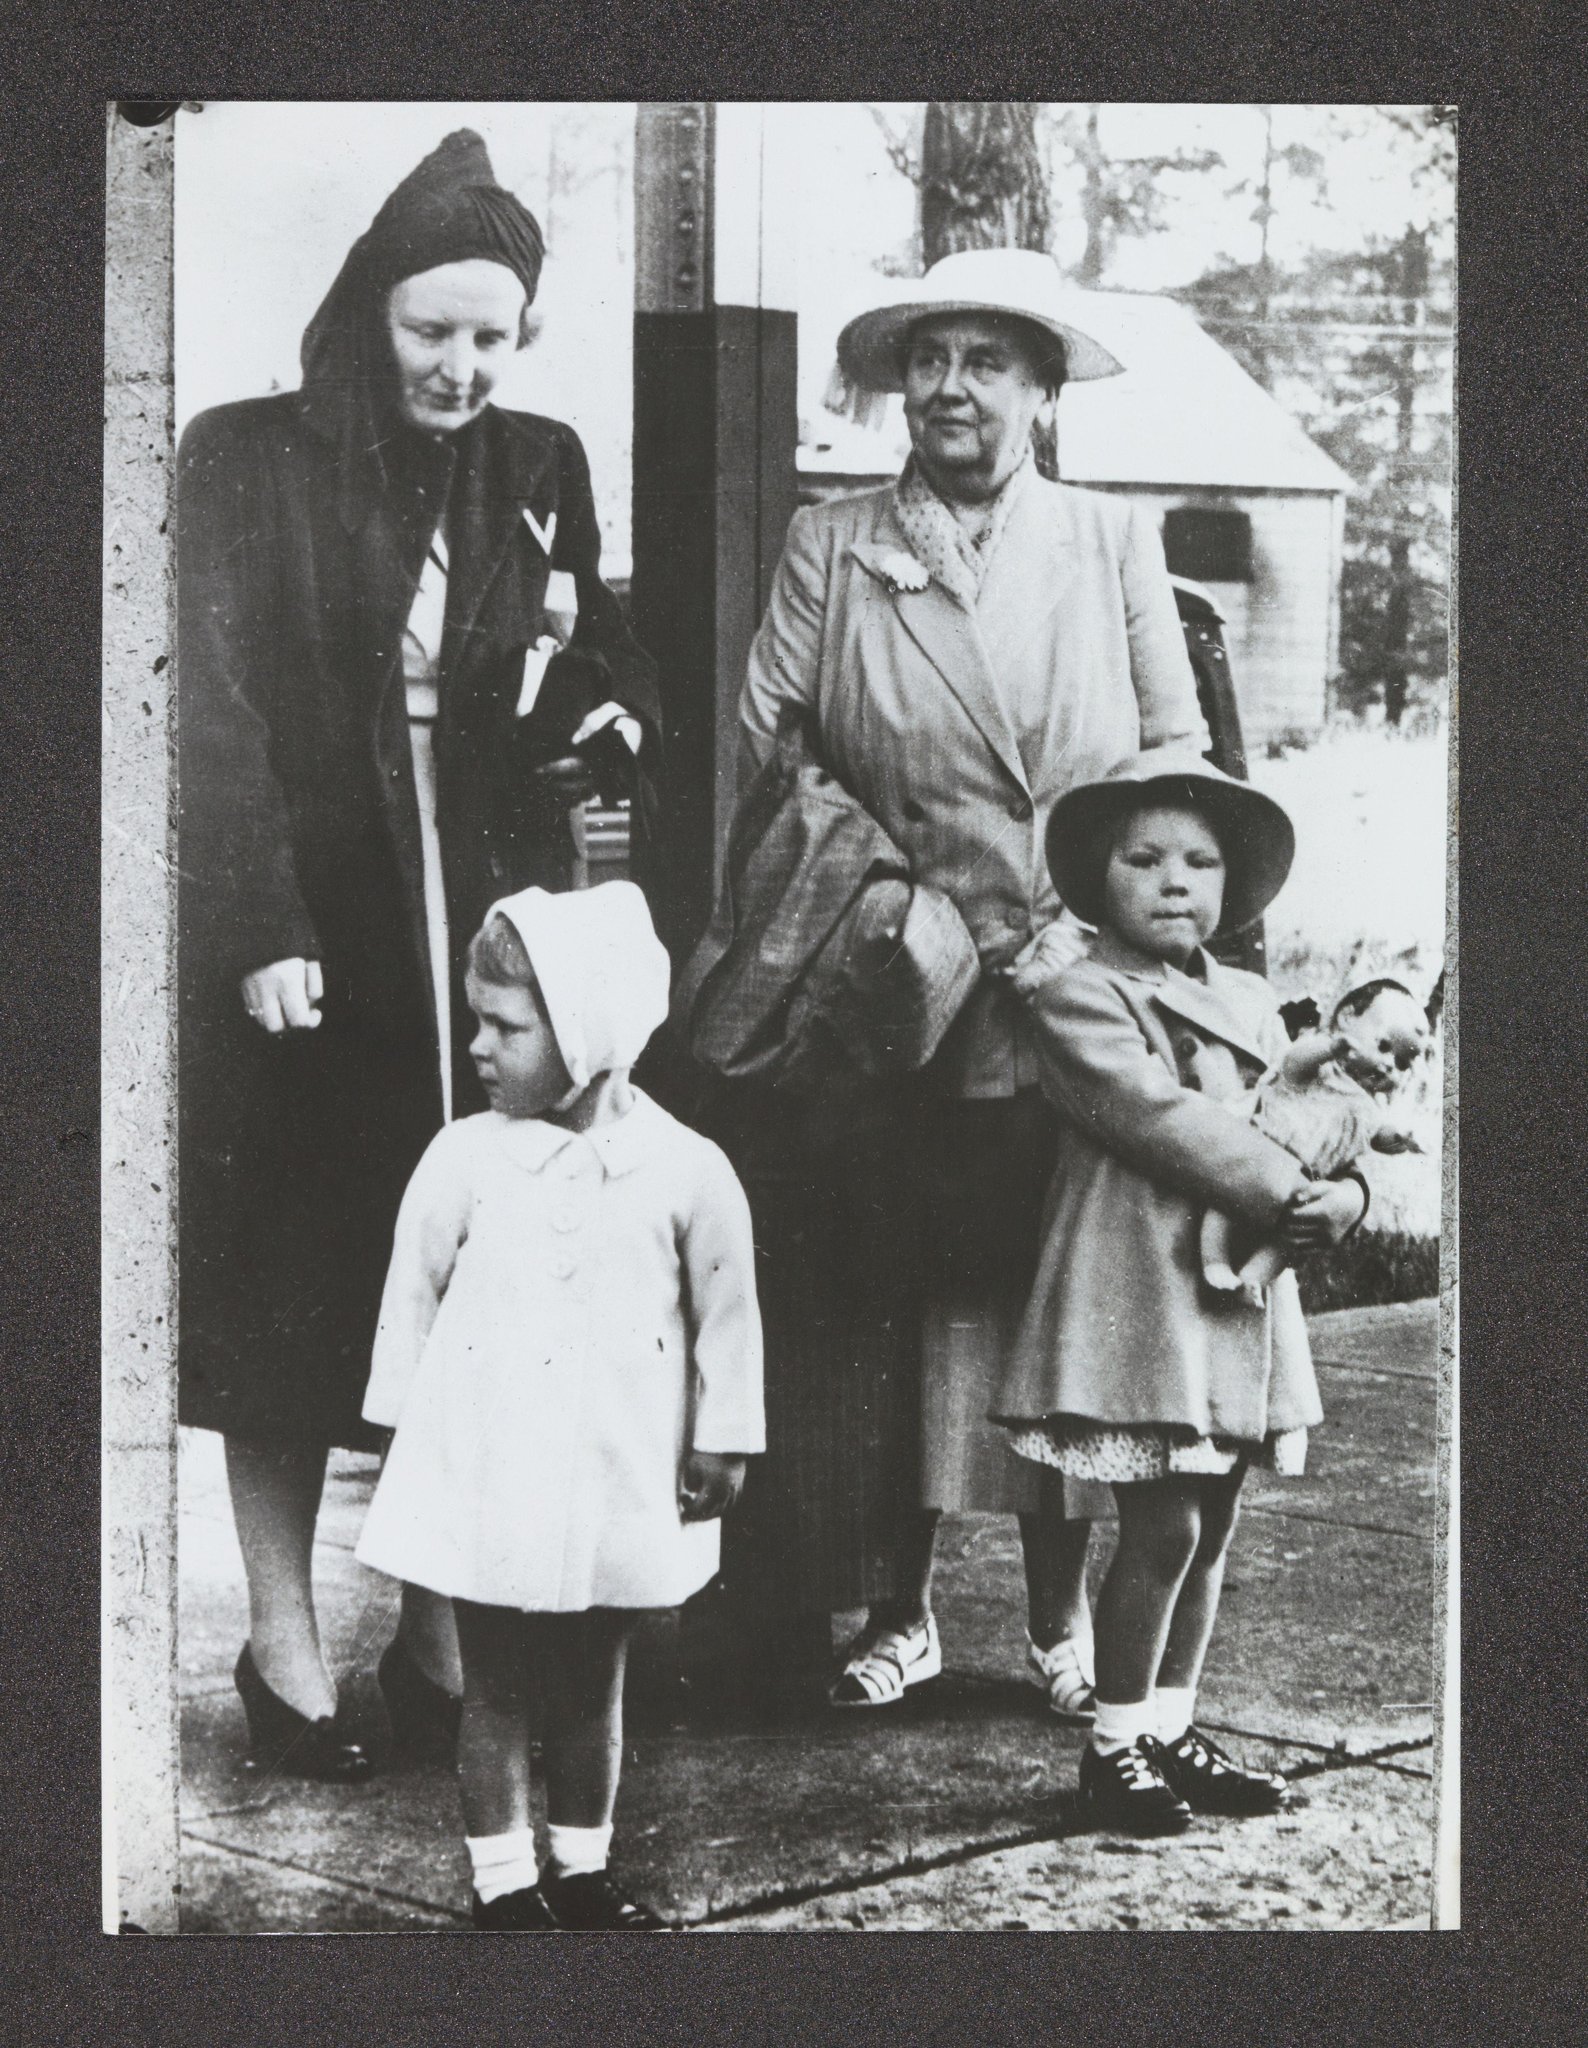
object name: photograph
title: Ver. Staten 1942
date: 1942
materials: paper, photographic support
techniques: gelatin silver print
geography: amsterdam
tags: the hague, print maker, wilhelmina of the netherlands, beatrix (koningin der nederlanden), juliana of the netherlands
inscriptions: stamp: ‘Copyright ANEFO Kerkstraat 310 Amsterdam-c’